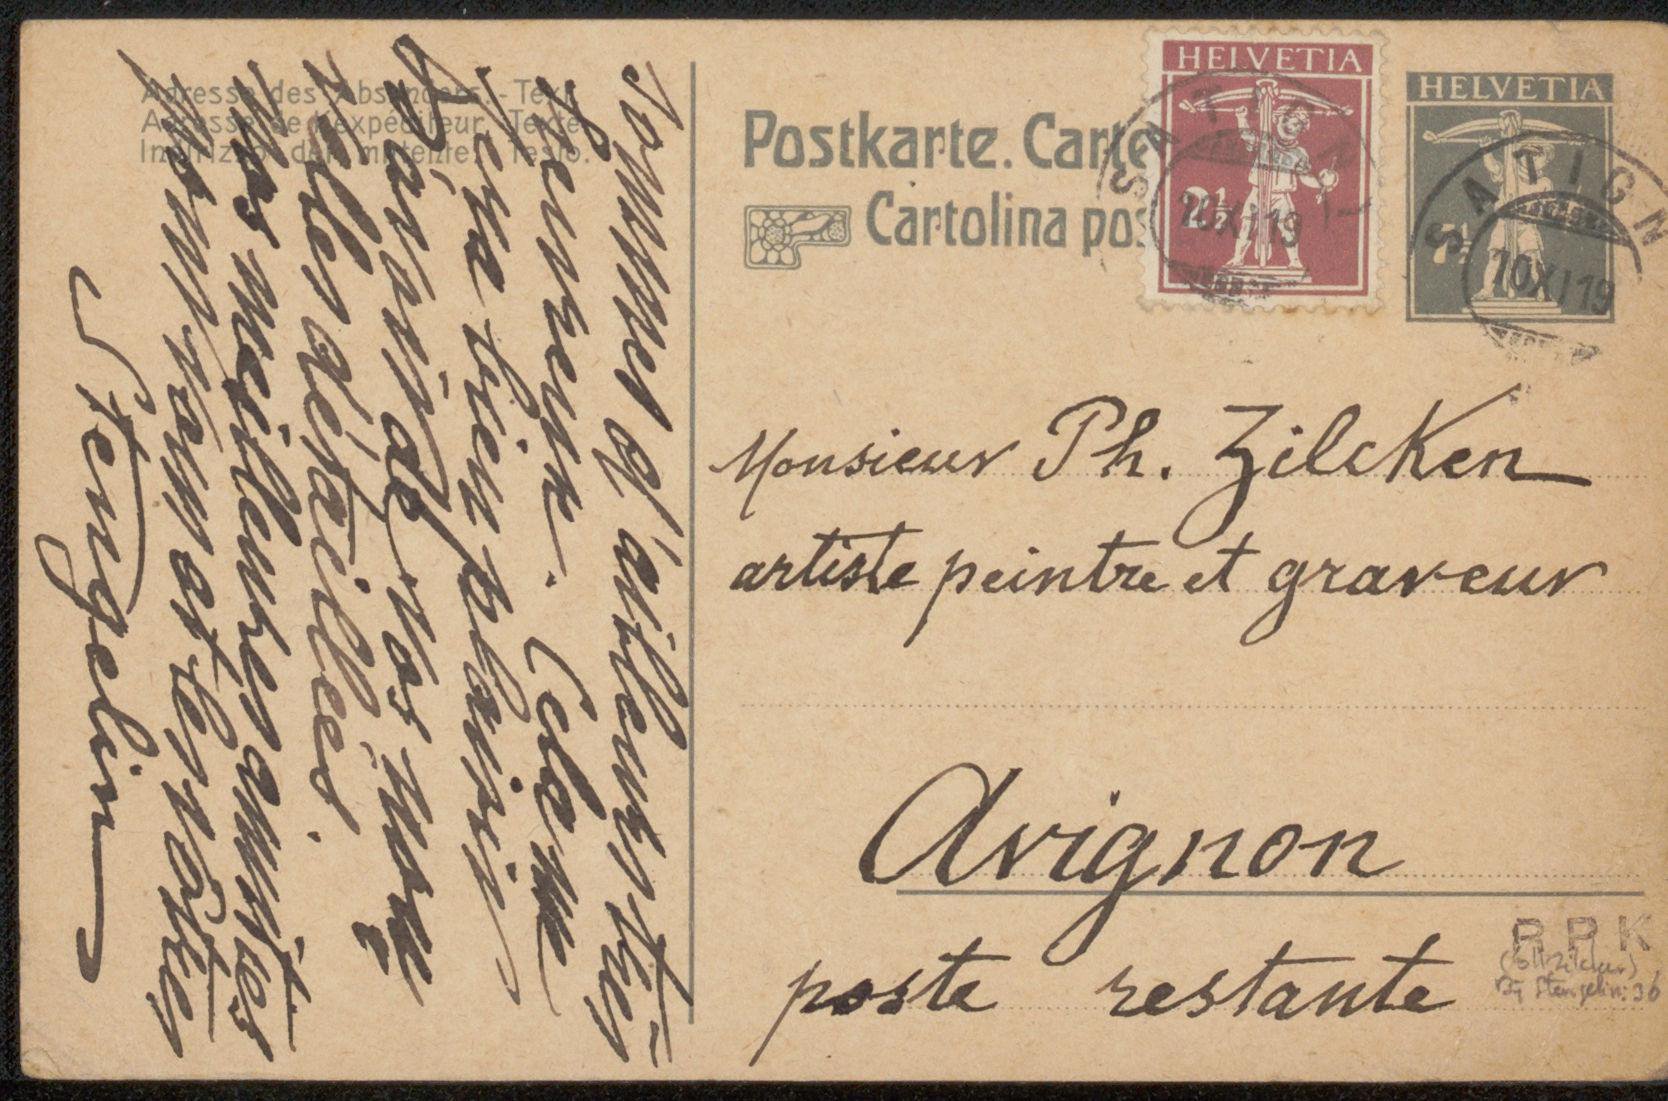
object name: postcard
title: Briefkaart aan Philip Zilcken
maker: alphonse stengelin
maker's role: painter, print maker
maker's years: 1852-1938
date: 1919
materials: cardboard, ink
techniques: pen, writing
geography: satigny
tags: voorburg, renée hélène laure zilcken, the hague, painter, draughtsman, philip zilcken, architecture, switzerland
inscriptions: collector's mark: ‘RPK’